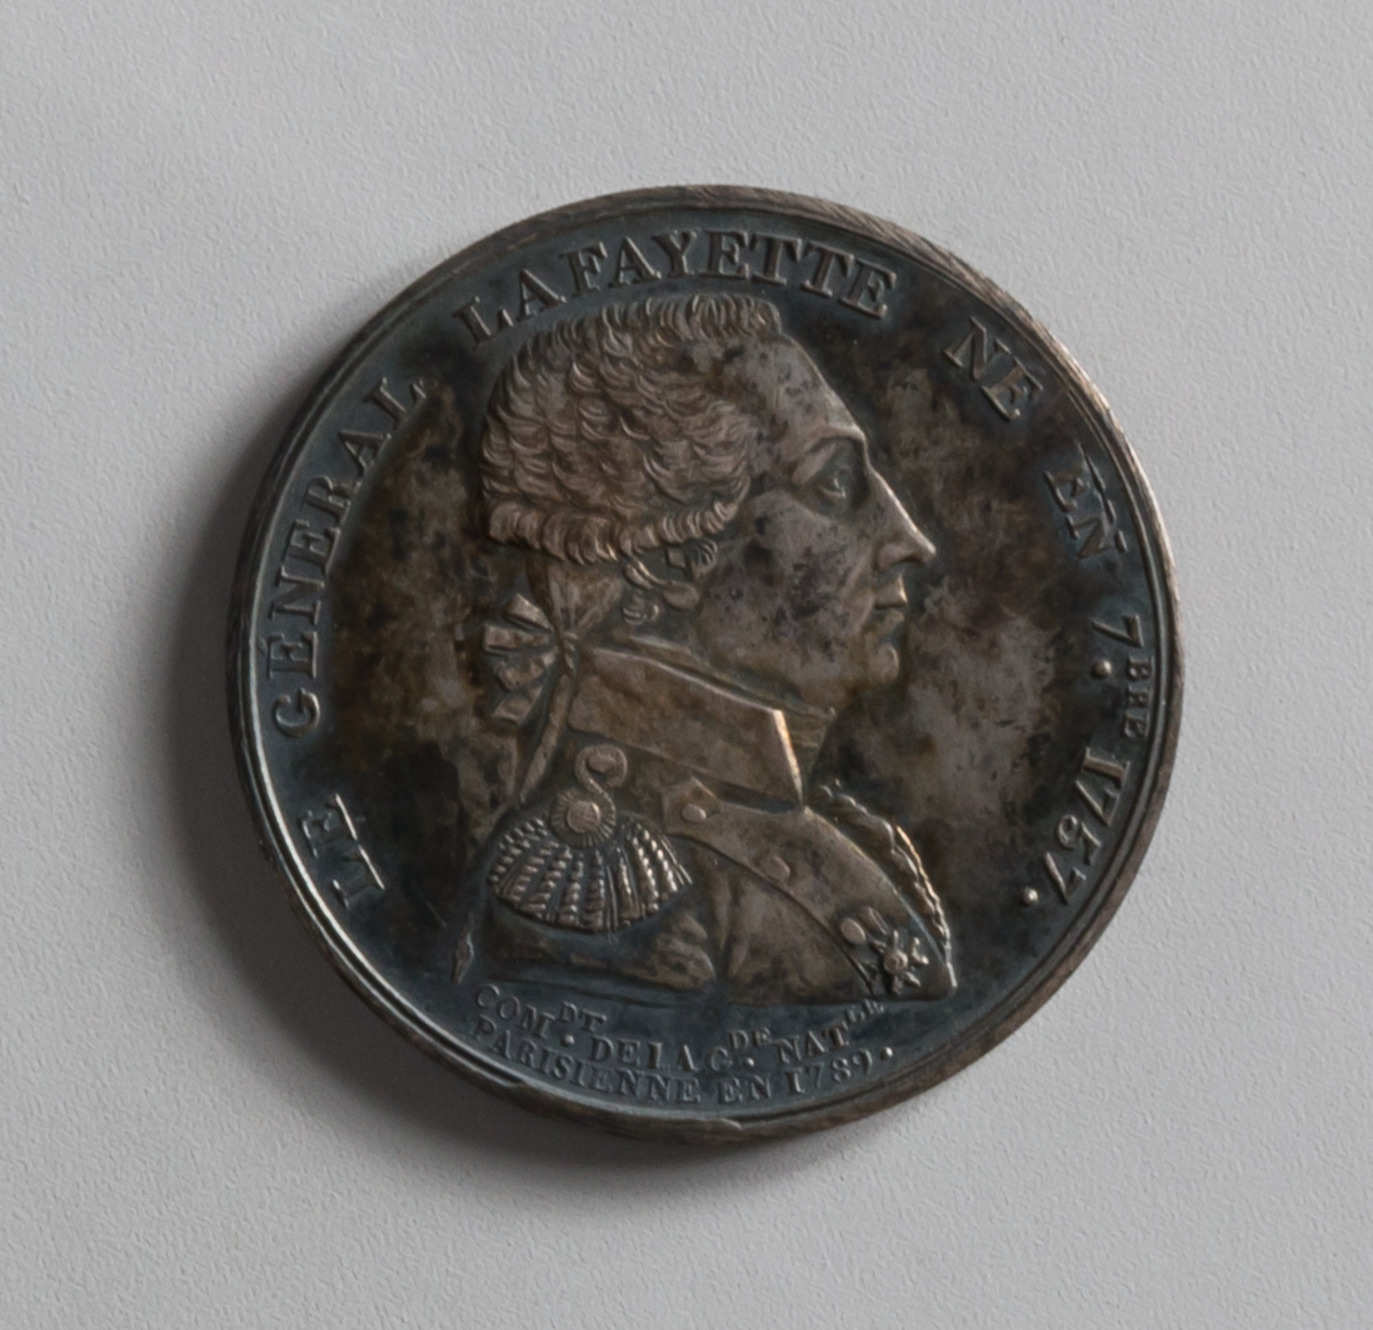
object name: medal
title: Medal of the Marquis de Lafayette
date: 1834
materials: silver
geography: france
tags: men,profiles,marquis de lafayette